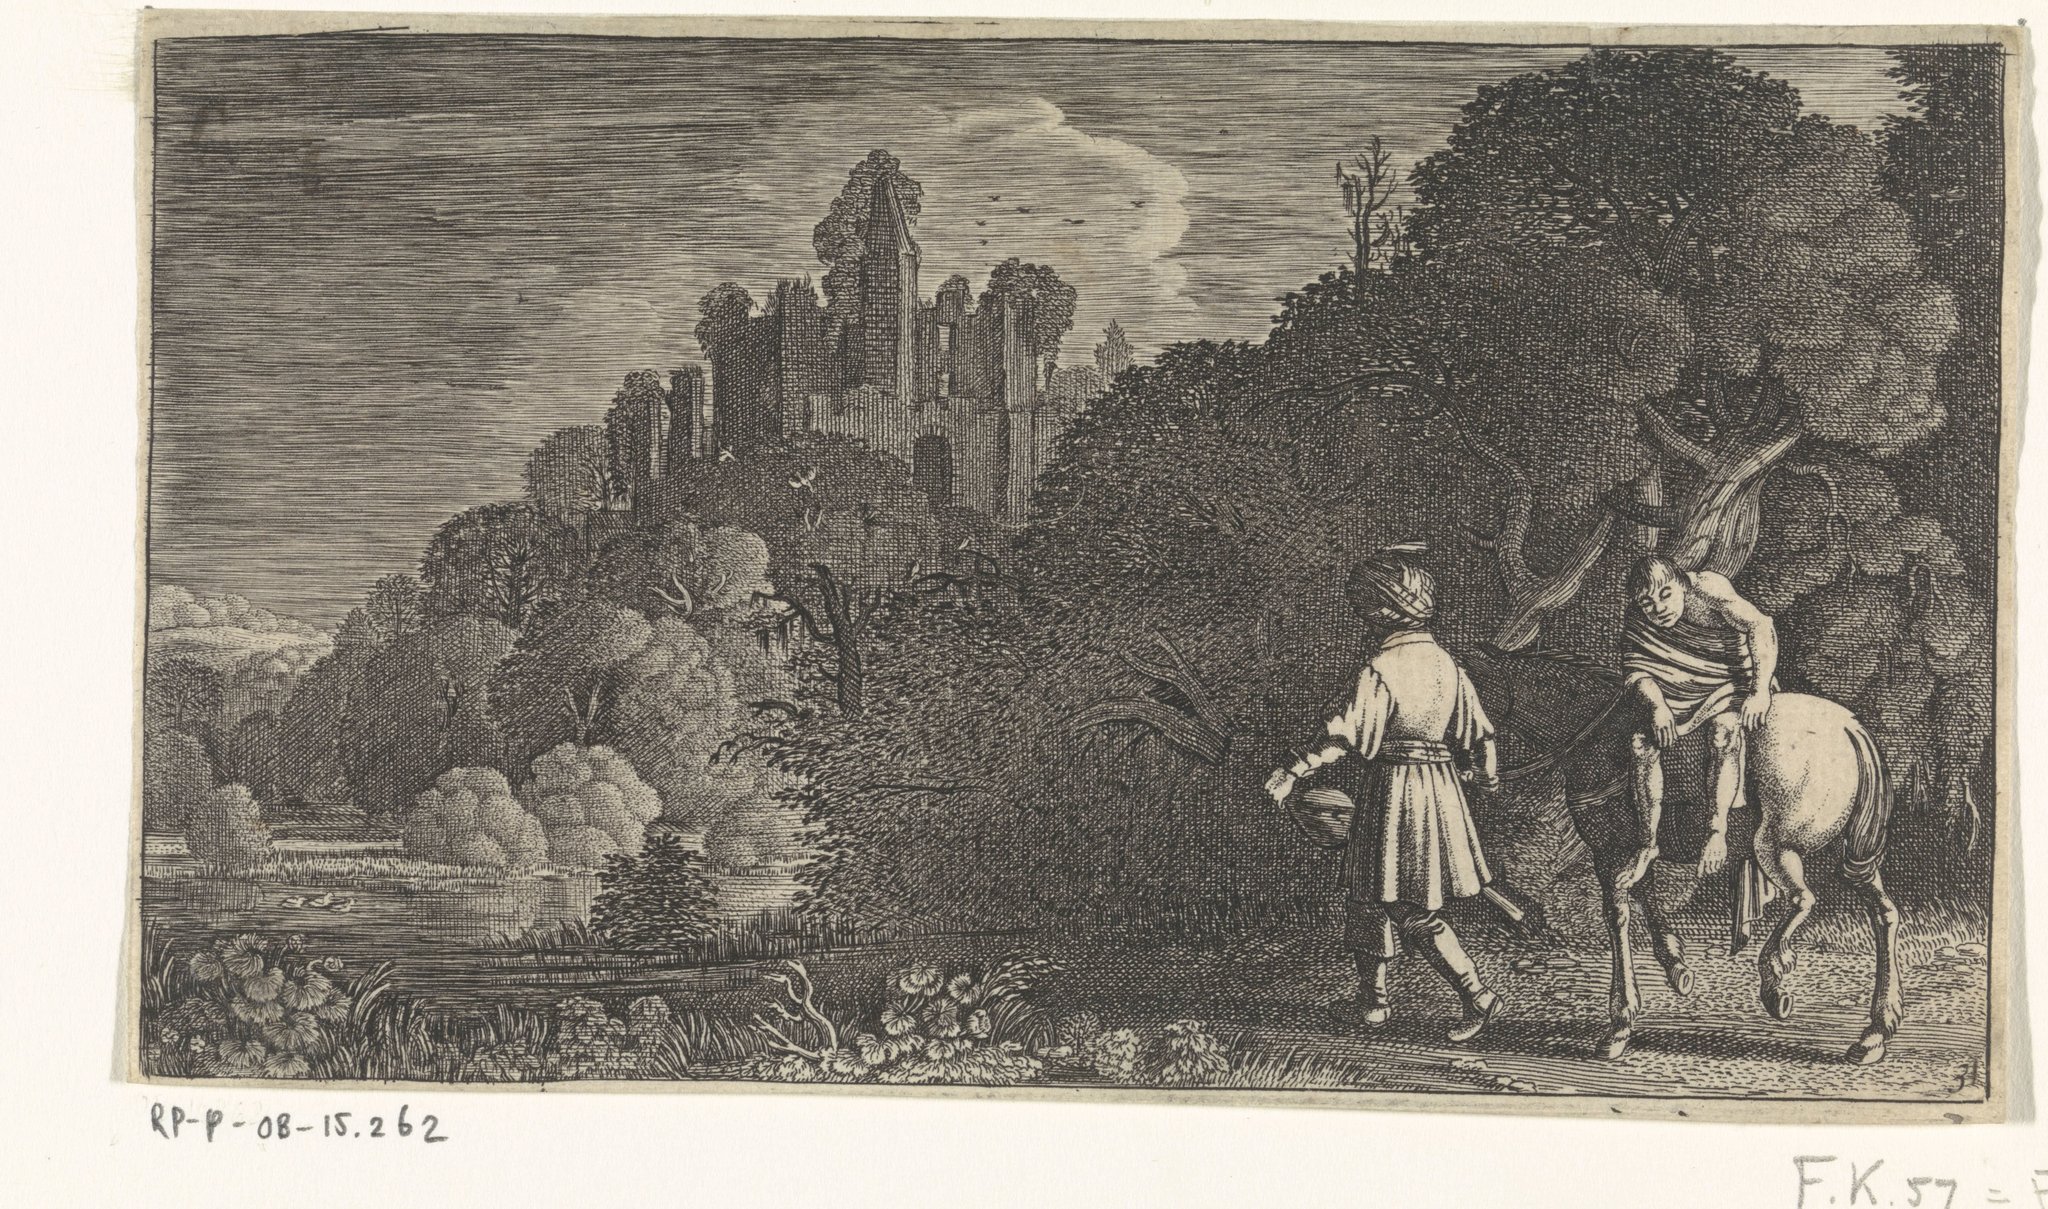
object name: print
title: Barmhartige Samaritaan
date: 1603-1652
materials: paper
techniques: engraving, etching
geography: northern netherlands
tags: dusk, evening twilight, the good samaritan (luke 10:30-37), the samaritan sets the wounded traveller on his mount (ass or horse), and brings him to an inn, evening ~ landscape (sometimes titled 'vesper')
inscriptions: inscription: ‘no F 78’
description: De barmhartige Samaritaan voert de gewonde reiziger op zijn ezel door een donker landschap. Linksachter de ruïne van een kasteel op een heuvel. Prent uit een serie van vier.